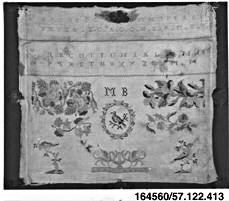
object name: sampler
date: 1801-1900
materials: linen, silk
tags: birds,flowers